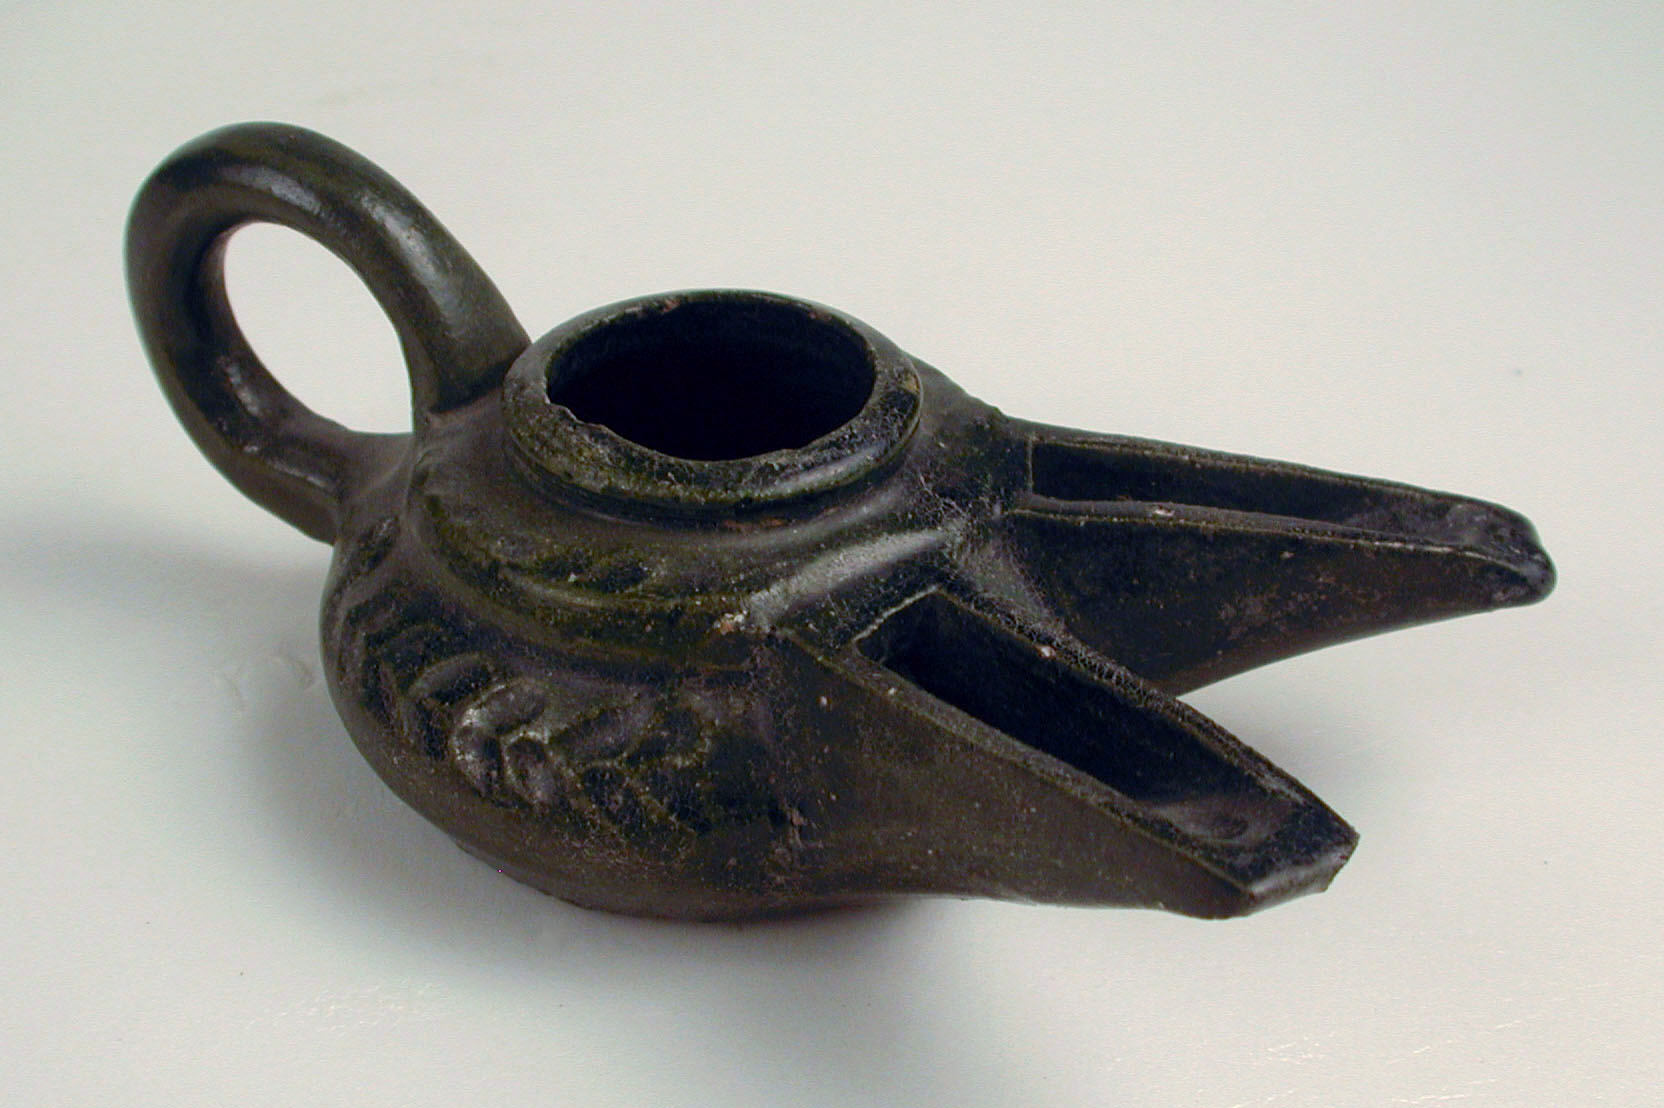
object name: lamp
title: Ceramic Oil Lamp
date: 901-1000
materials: earthenware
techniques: glazing, molding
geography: central asia